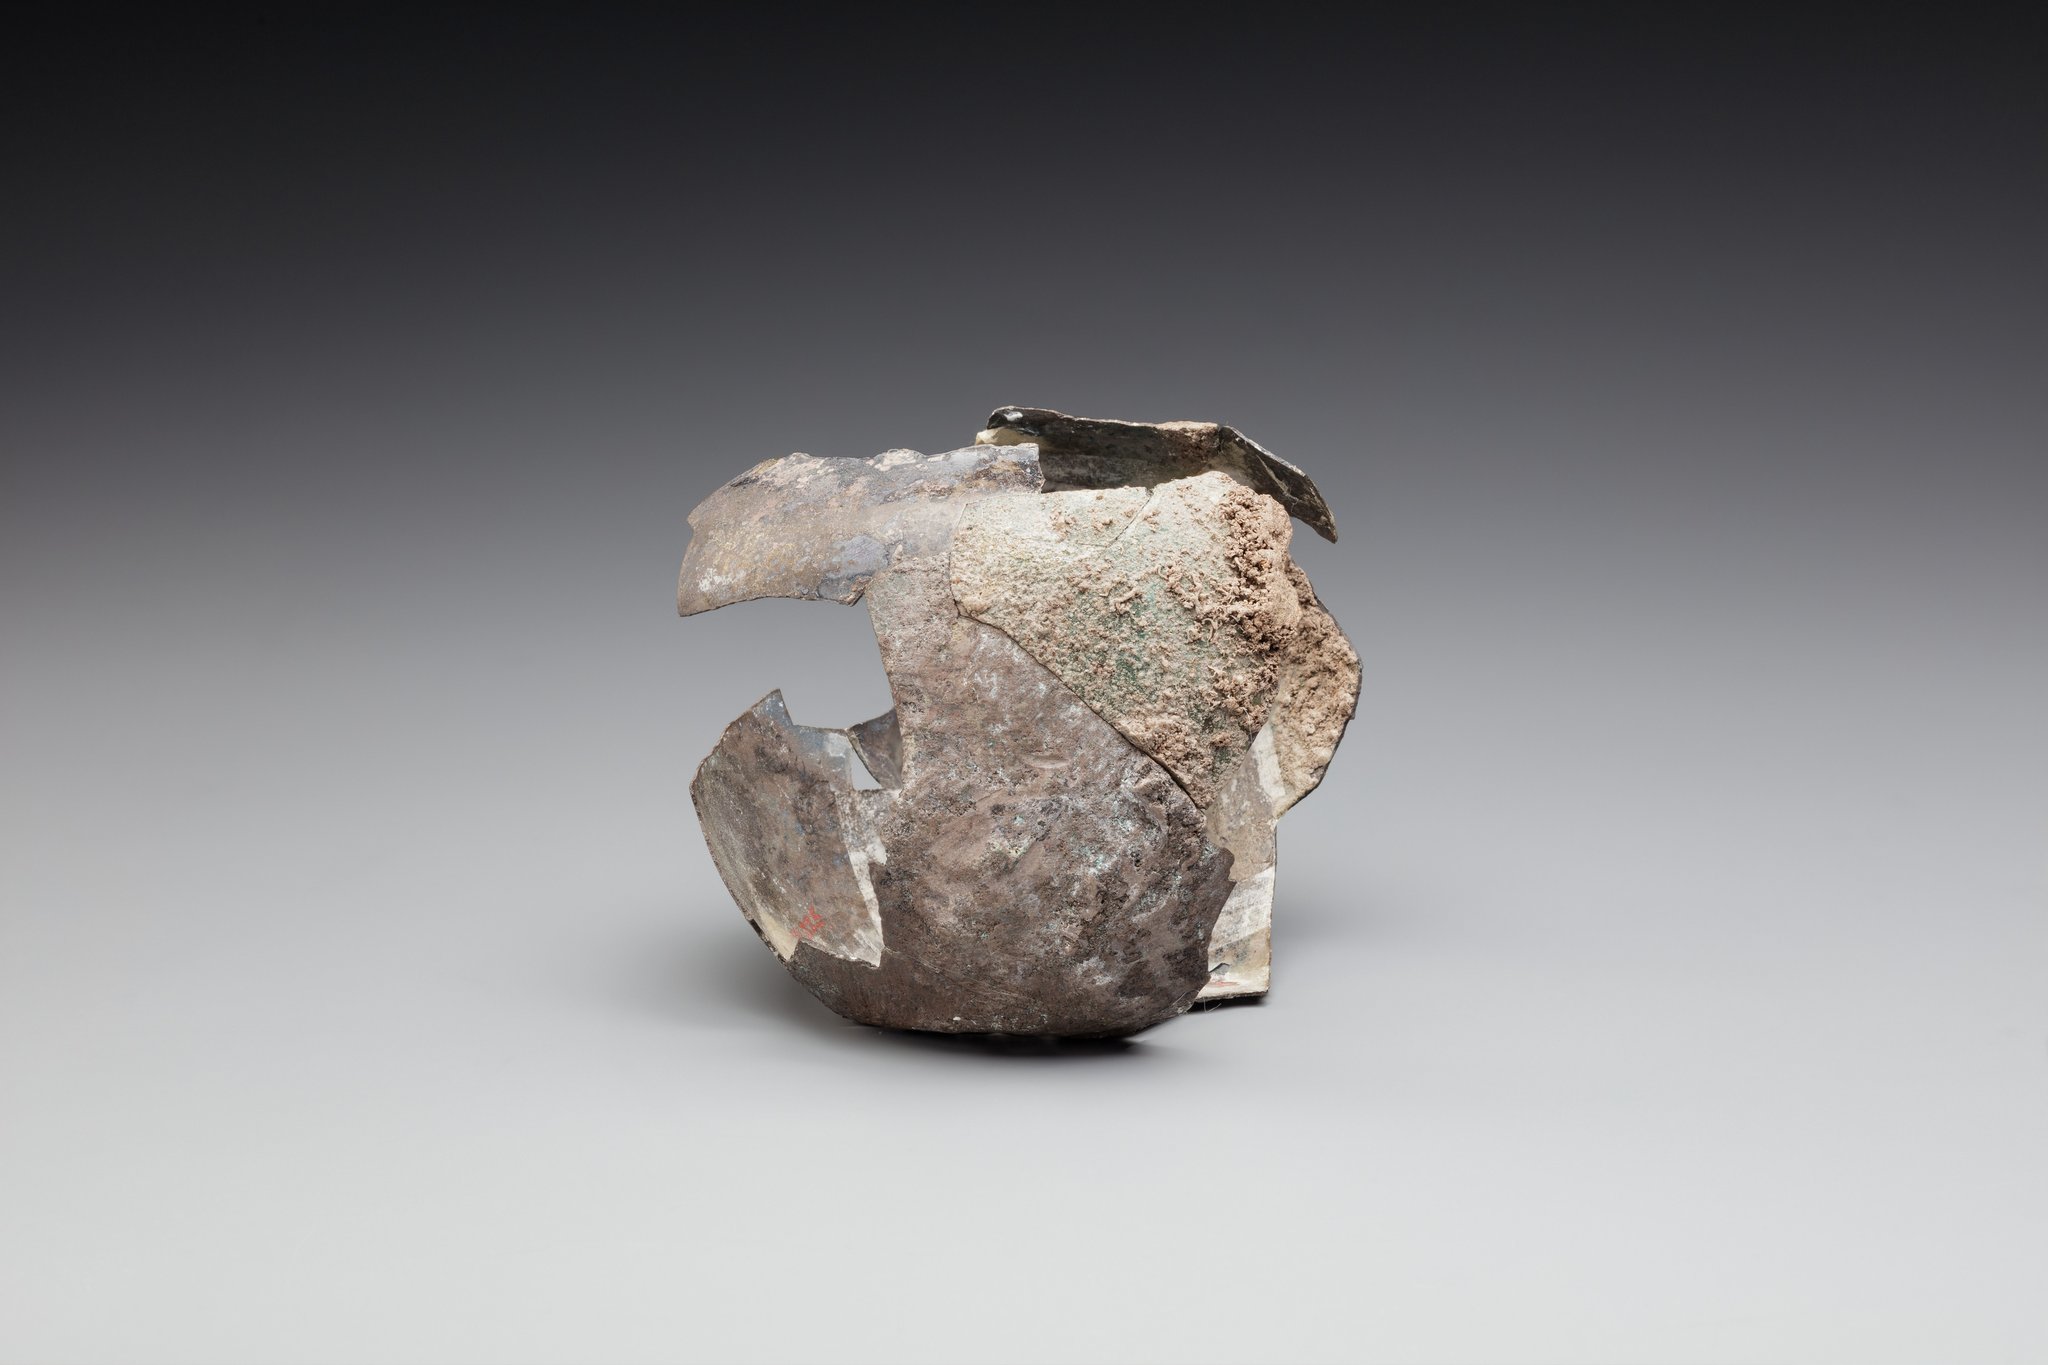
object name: body jar fragment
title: Jar fragment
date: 1295-1070 BCE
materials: silver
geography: egypt